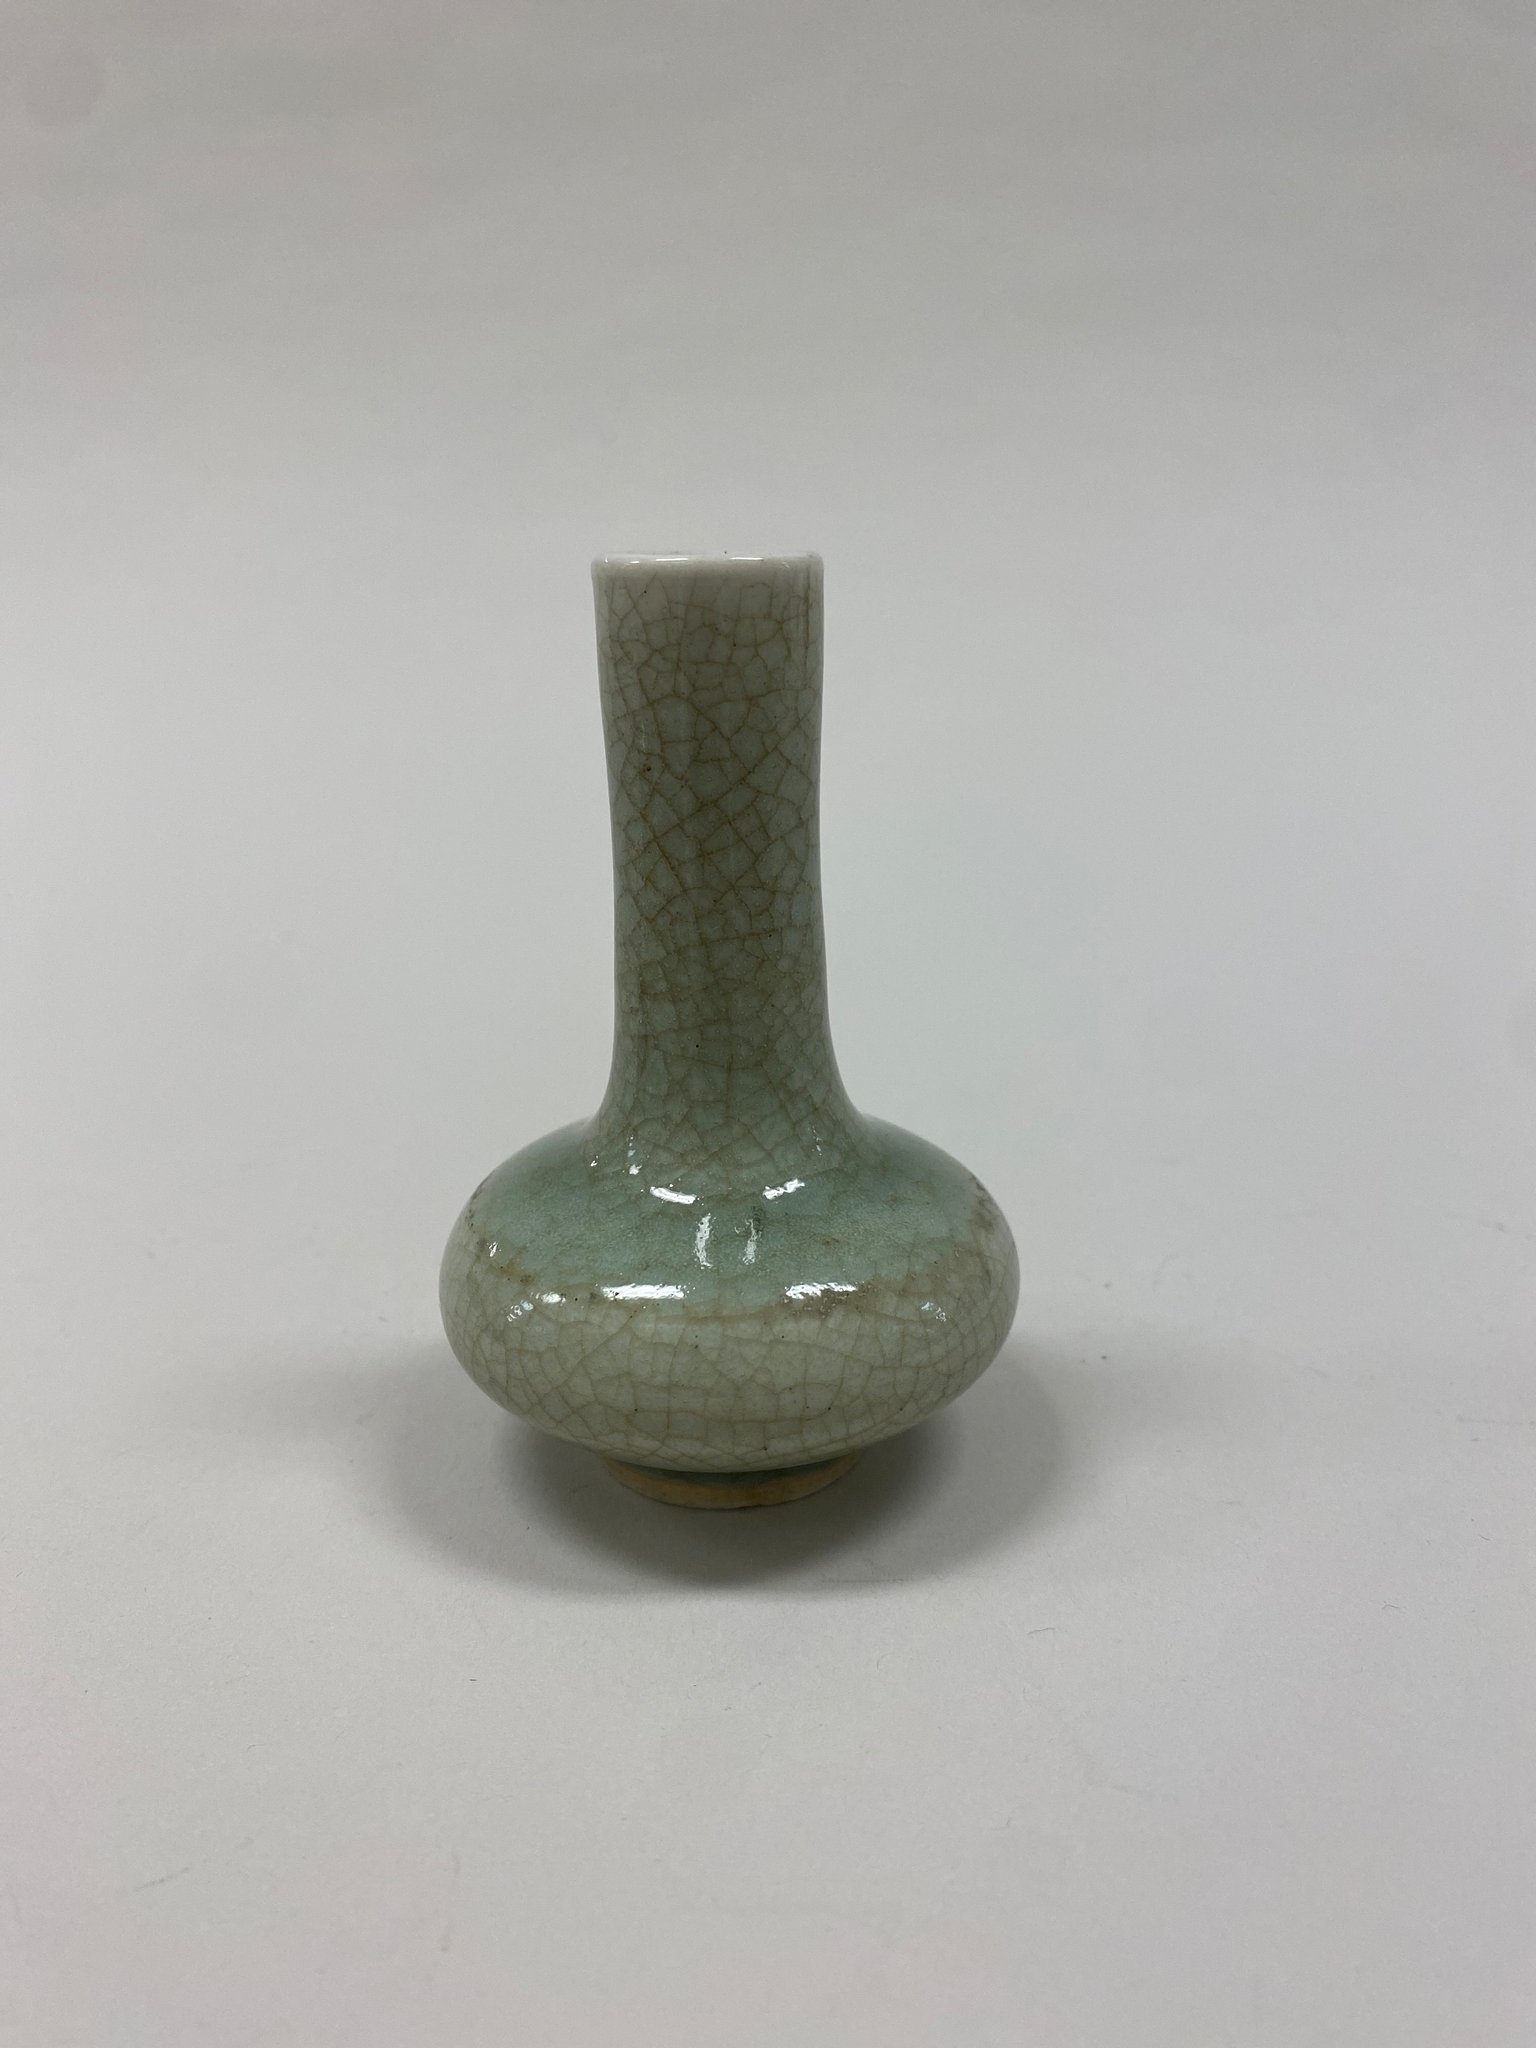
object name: vase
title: Miniature vase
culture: chinese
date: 1701-1800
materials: glaze, porcelain